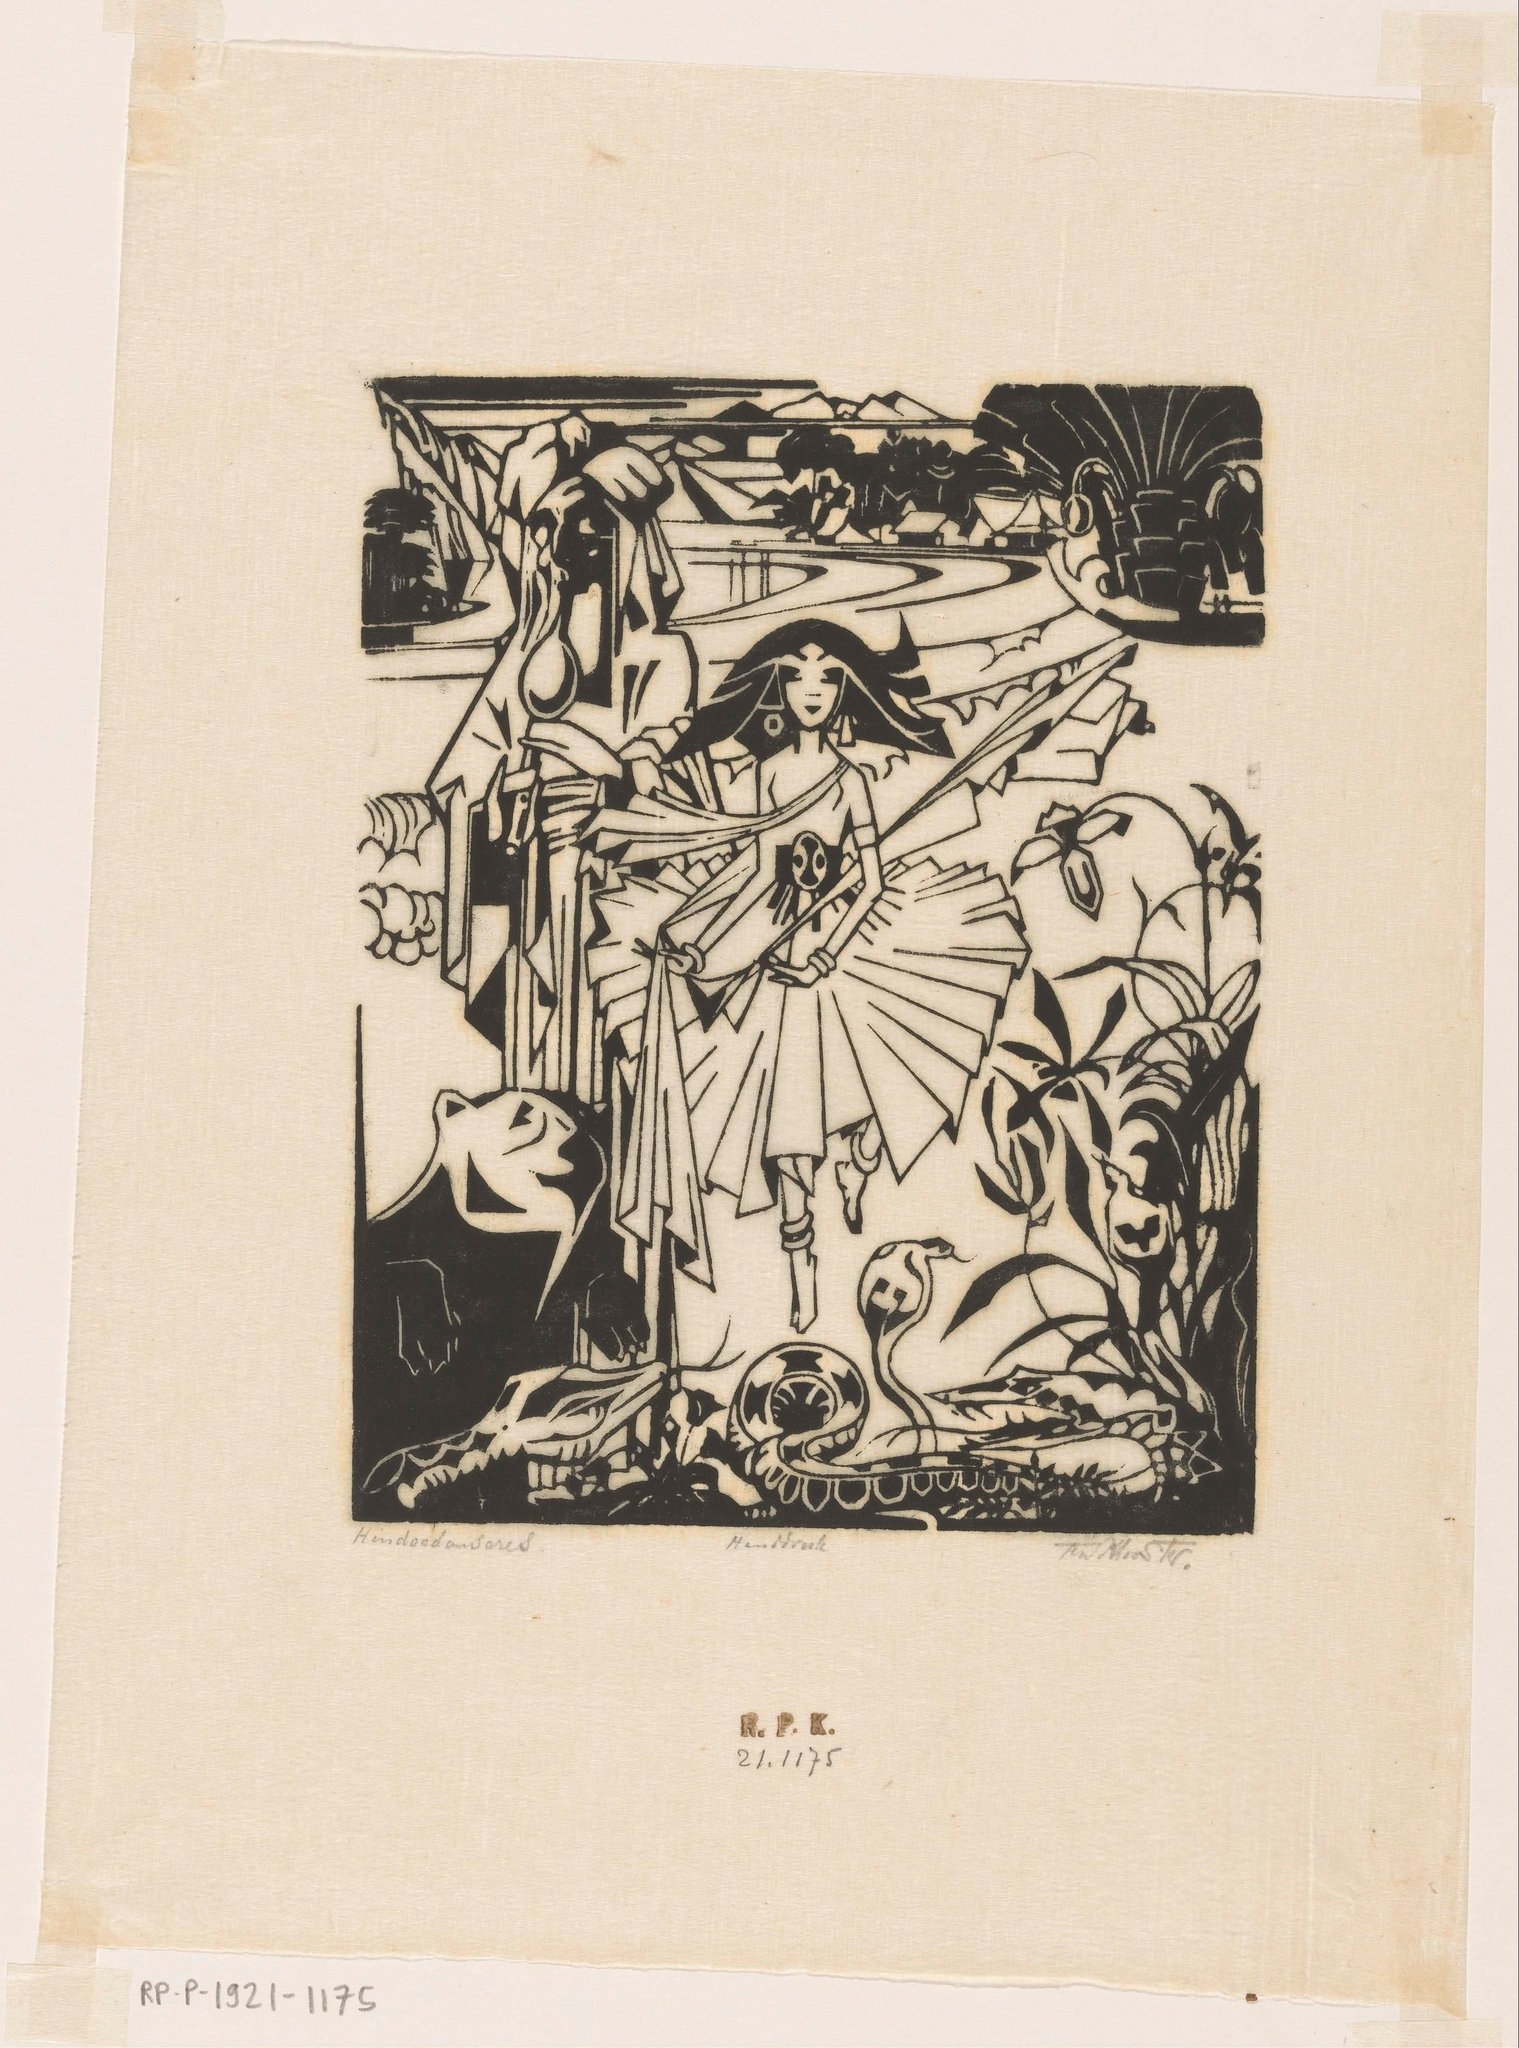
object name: print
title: Hindoedanseres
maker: johannes frederik engelbert ten klooster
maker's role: draughtsman, print maker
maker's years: 1873-1940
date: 1919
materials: paper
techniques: woodcut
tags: snakes, woman dancing alone, flute, aulos, tibia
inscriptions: collector's mark: Lugt 2233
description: Een dansende vrouw in een landschap met een dorp en bergen. Op de voorgrond verschillende dieren, waaronder een cobra. Links van de vrouw een slangenbezweerder.